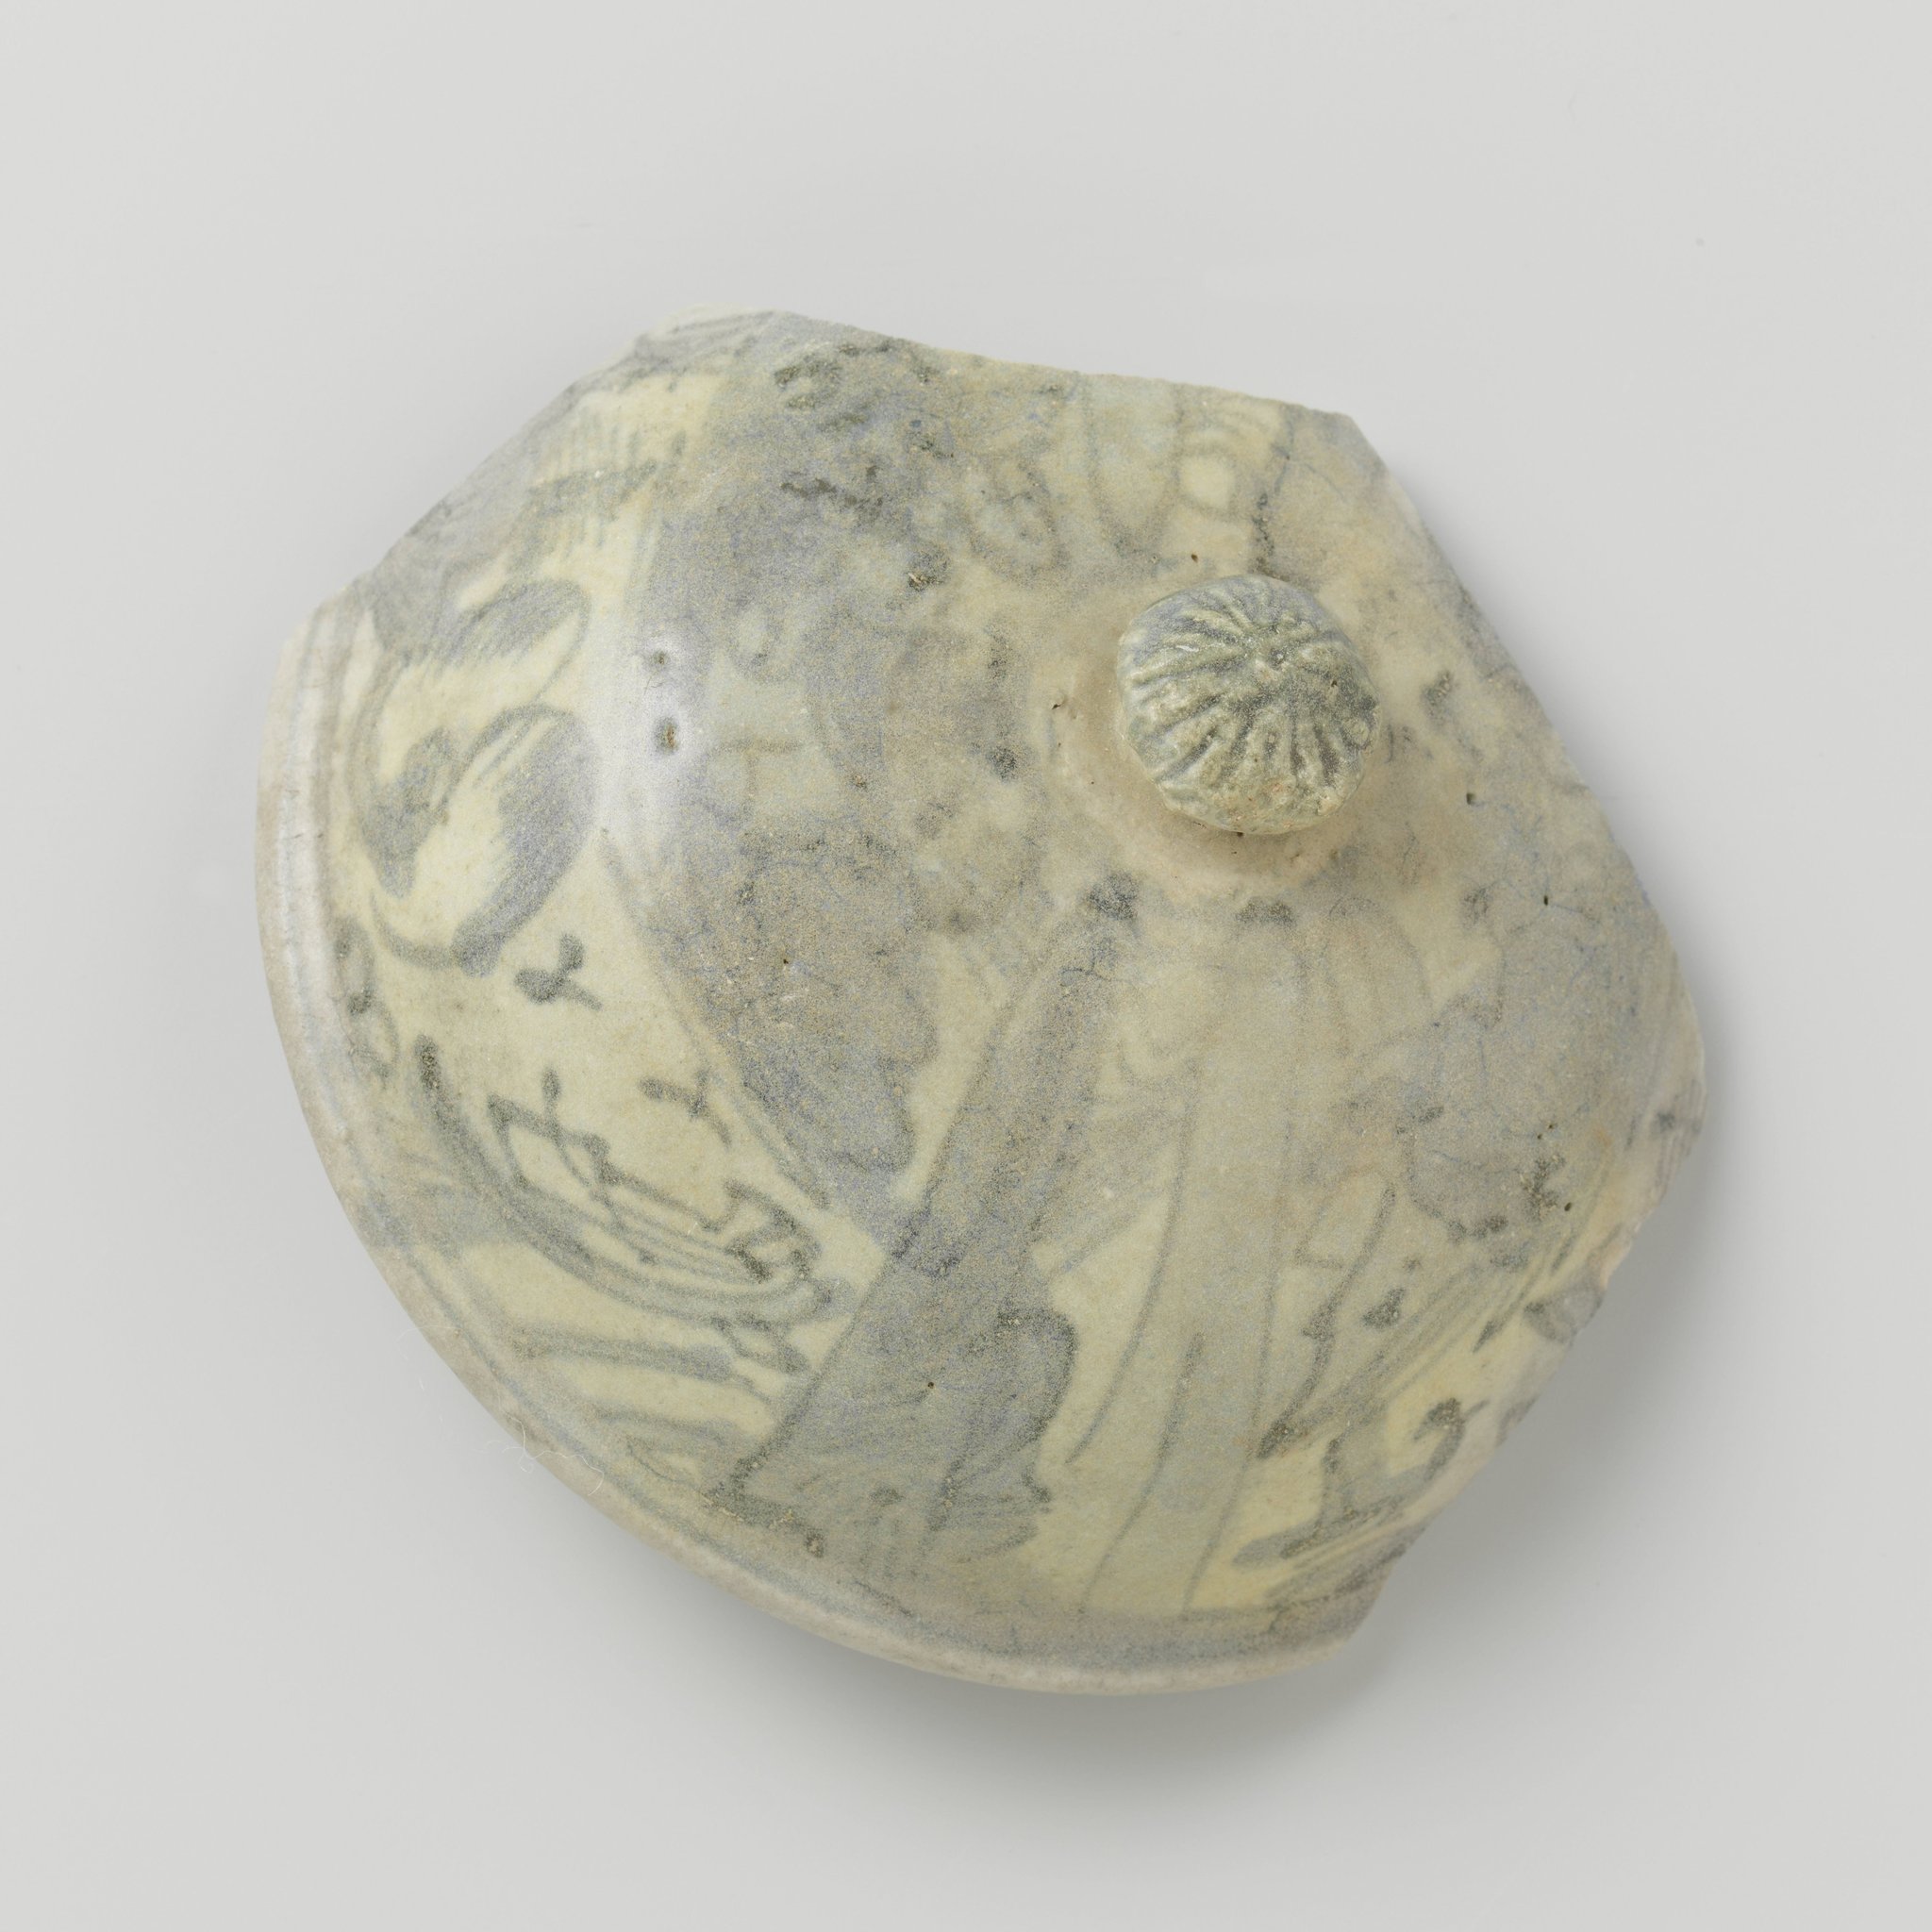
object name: lid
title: Deksel uit V.O.C.-schip de 'Witte Leeuw'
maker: Anonymous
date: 1613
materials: porcelain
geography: jingdezhen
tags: verenigde oostindische compagnie, sint-helena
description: A cover from a bowl. The cover is decorated with a stylized landscape with hills, water and pagodas.